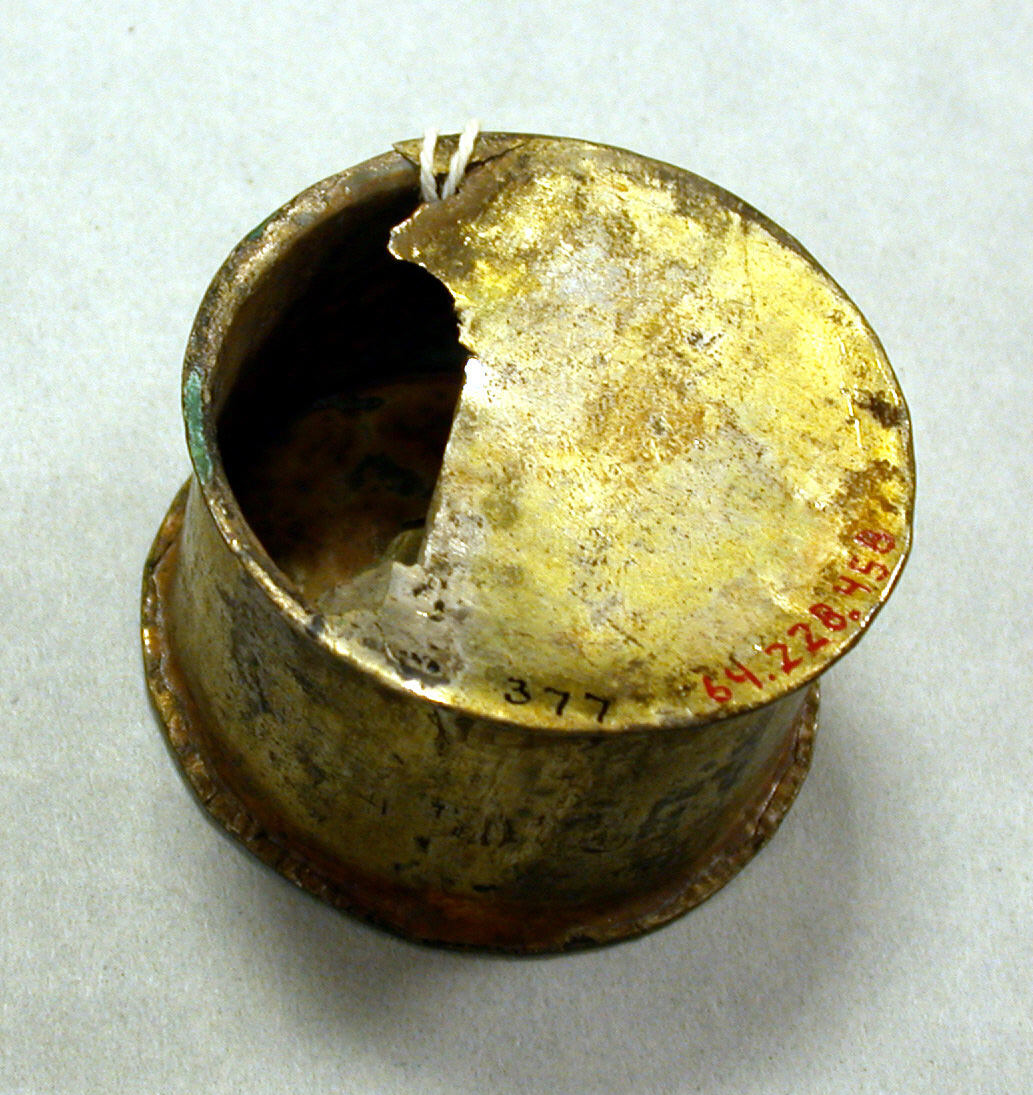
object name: drum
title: Hammered Silver Miniature Drum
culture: chancay or chimú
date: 1001-1466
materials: gilt, silver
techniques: hammering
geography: peru